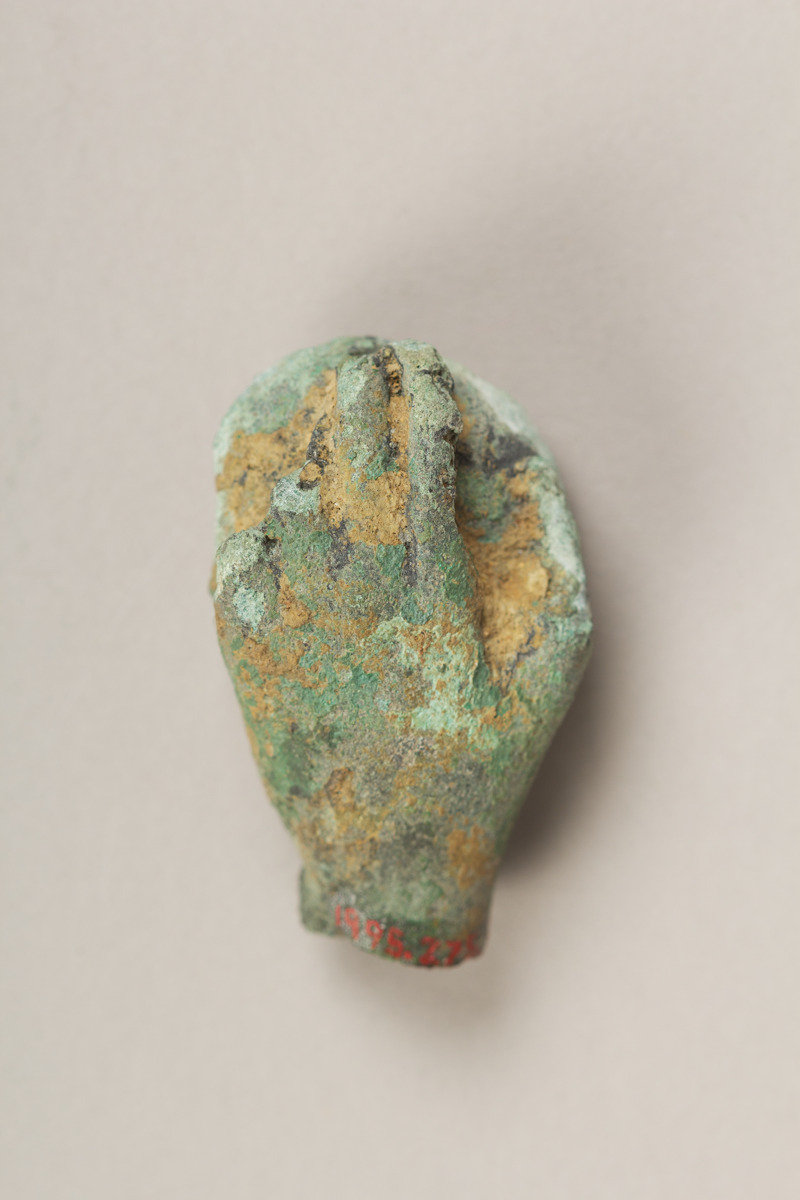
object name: fragment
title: Fragment of a Hand with a Bowl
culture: indonesian, kalimantan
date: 701-800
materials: bronze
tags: hands